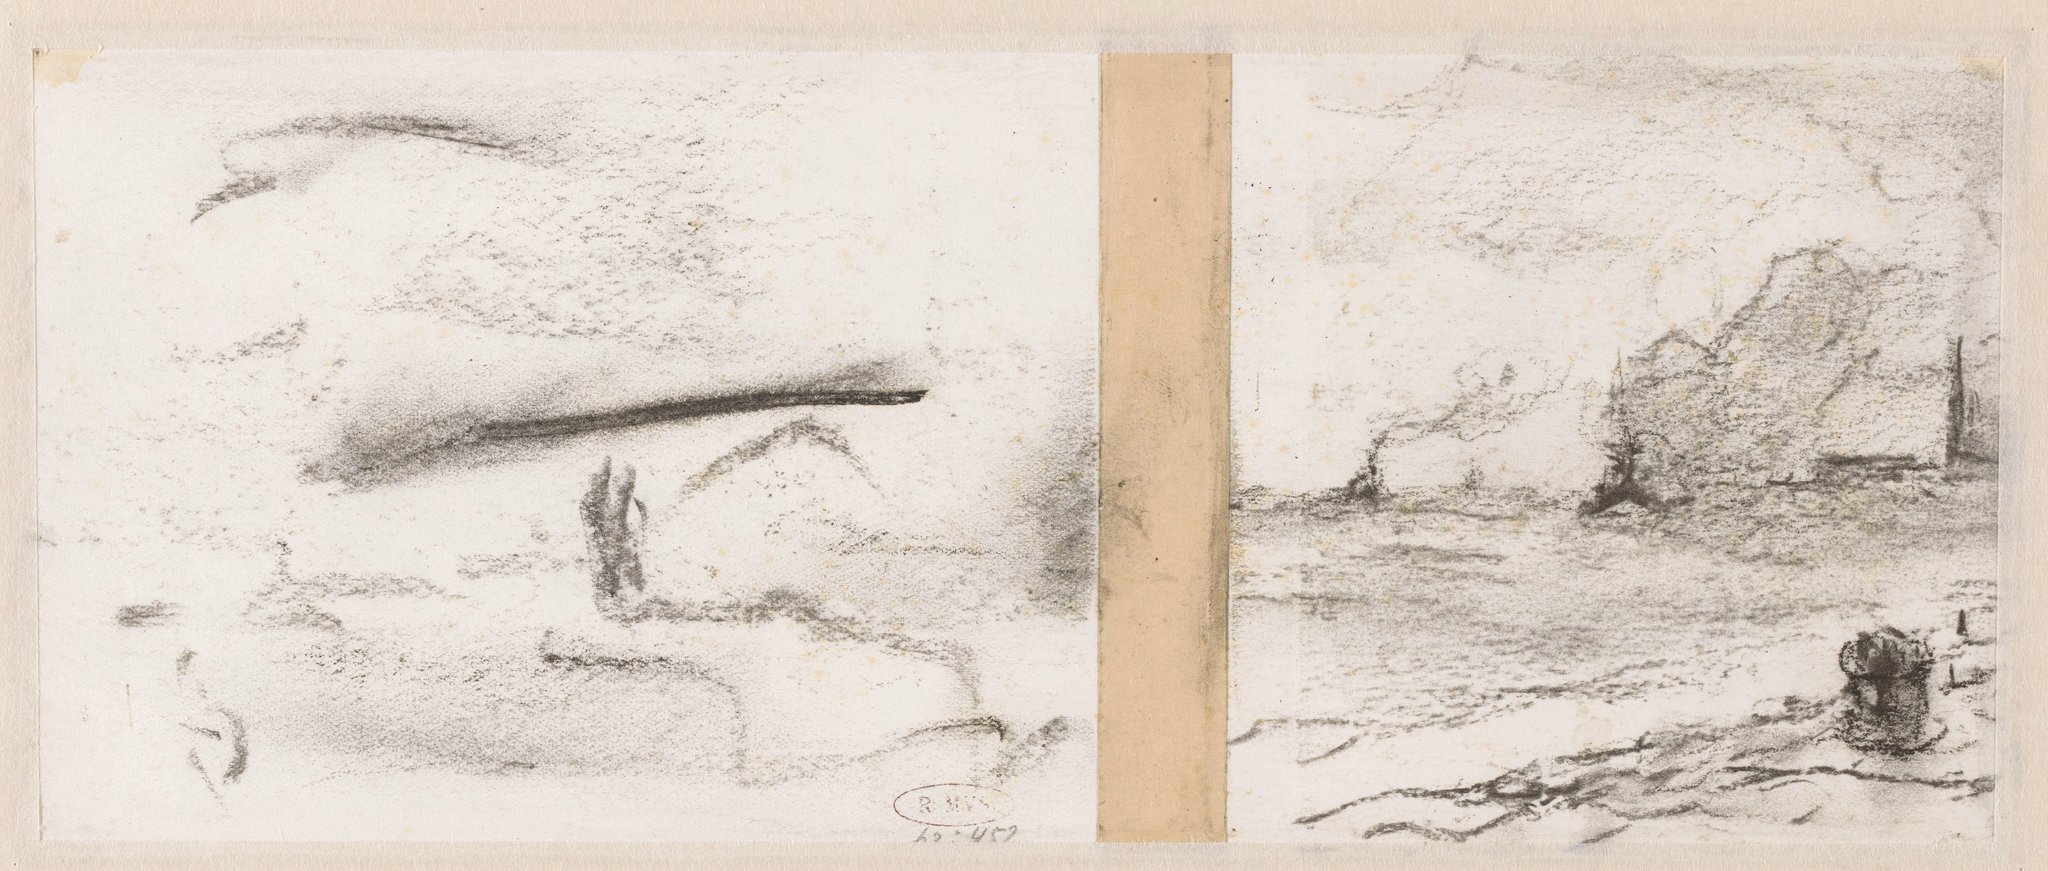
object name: drawing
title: Gezicht in de haven van Hamburg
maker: carel nicolaas storm van s-gravesande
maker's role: draughtsman, print maker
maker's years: 1841-1924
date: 1907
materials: chalk, paper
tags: harbour, germany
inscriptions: date